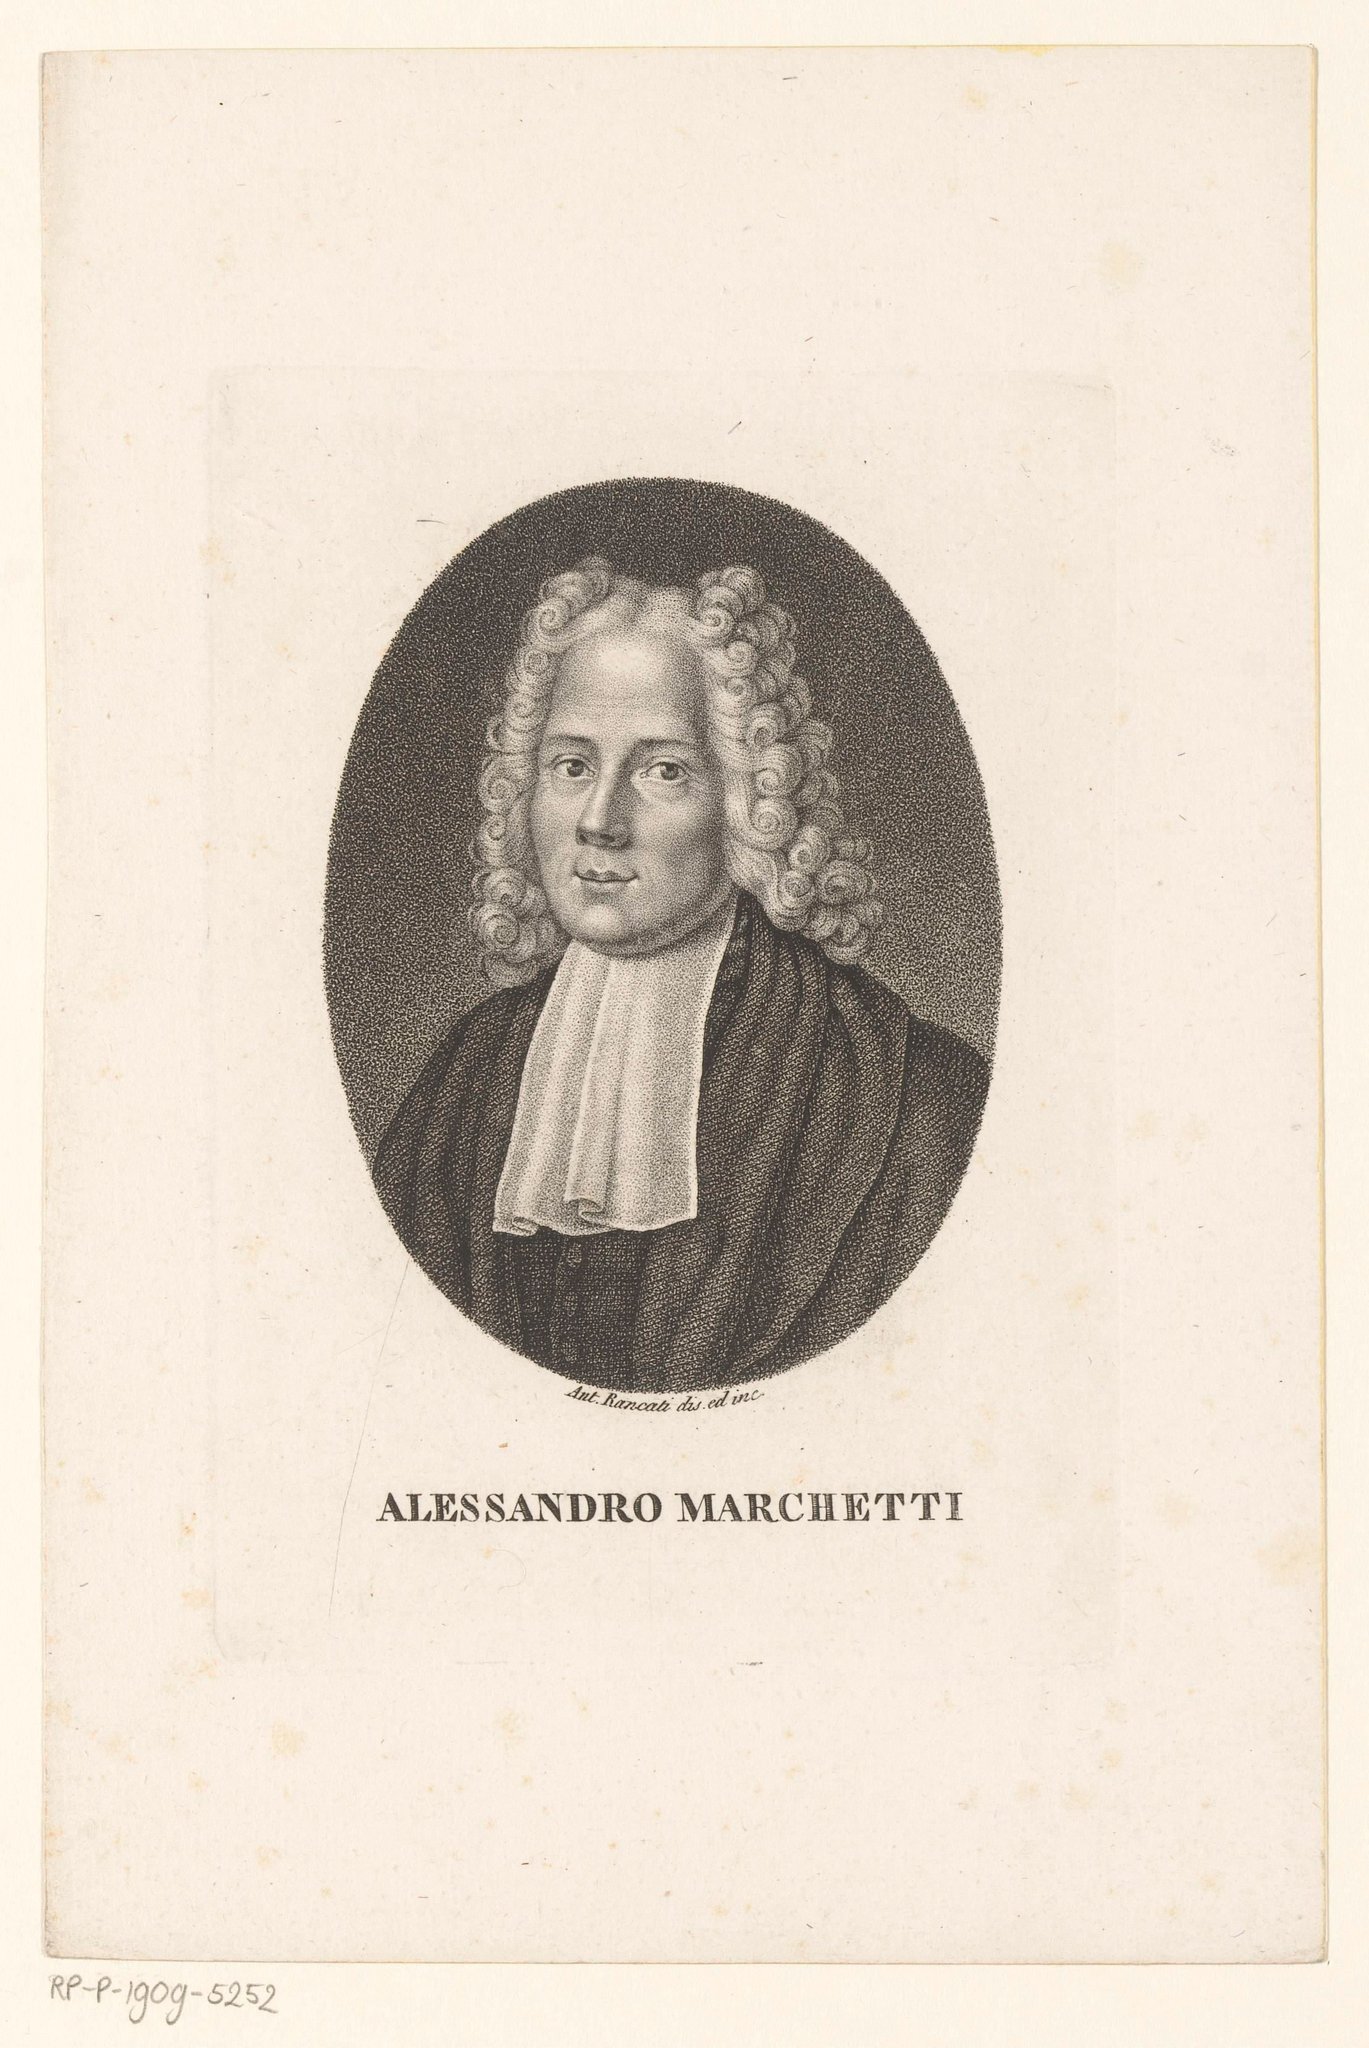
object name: print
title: Portret van wiskundige Alessandro Marchetti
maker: antonio rancati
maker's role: print maker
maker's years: 1784-1816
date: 1794-1816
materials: paper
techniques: etching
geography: italy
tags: historical persons, science and technology (+ portrait of scholar, scientist)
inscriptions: collector's mark: Lugt 2228